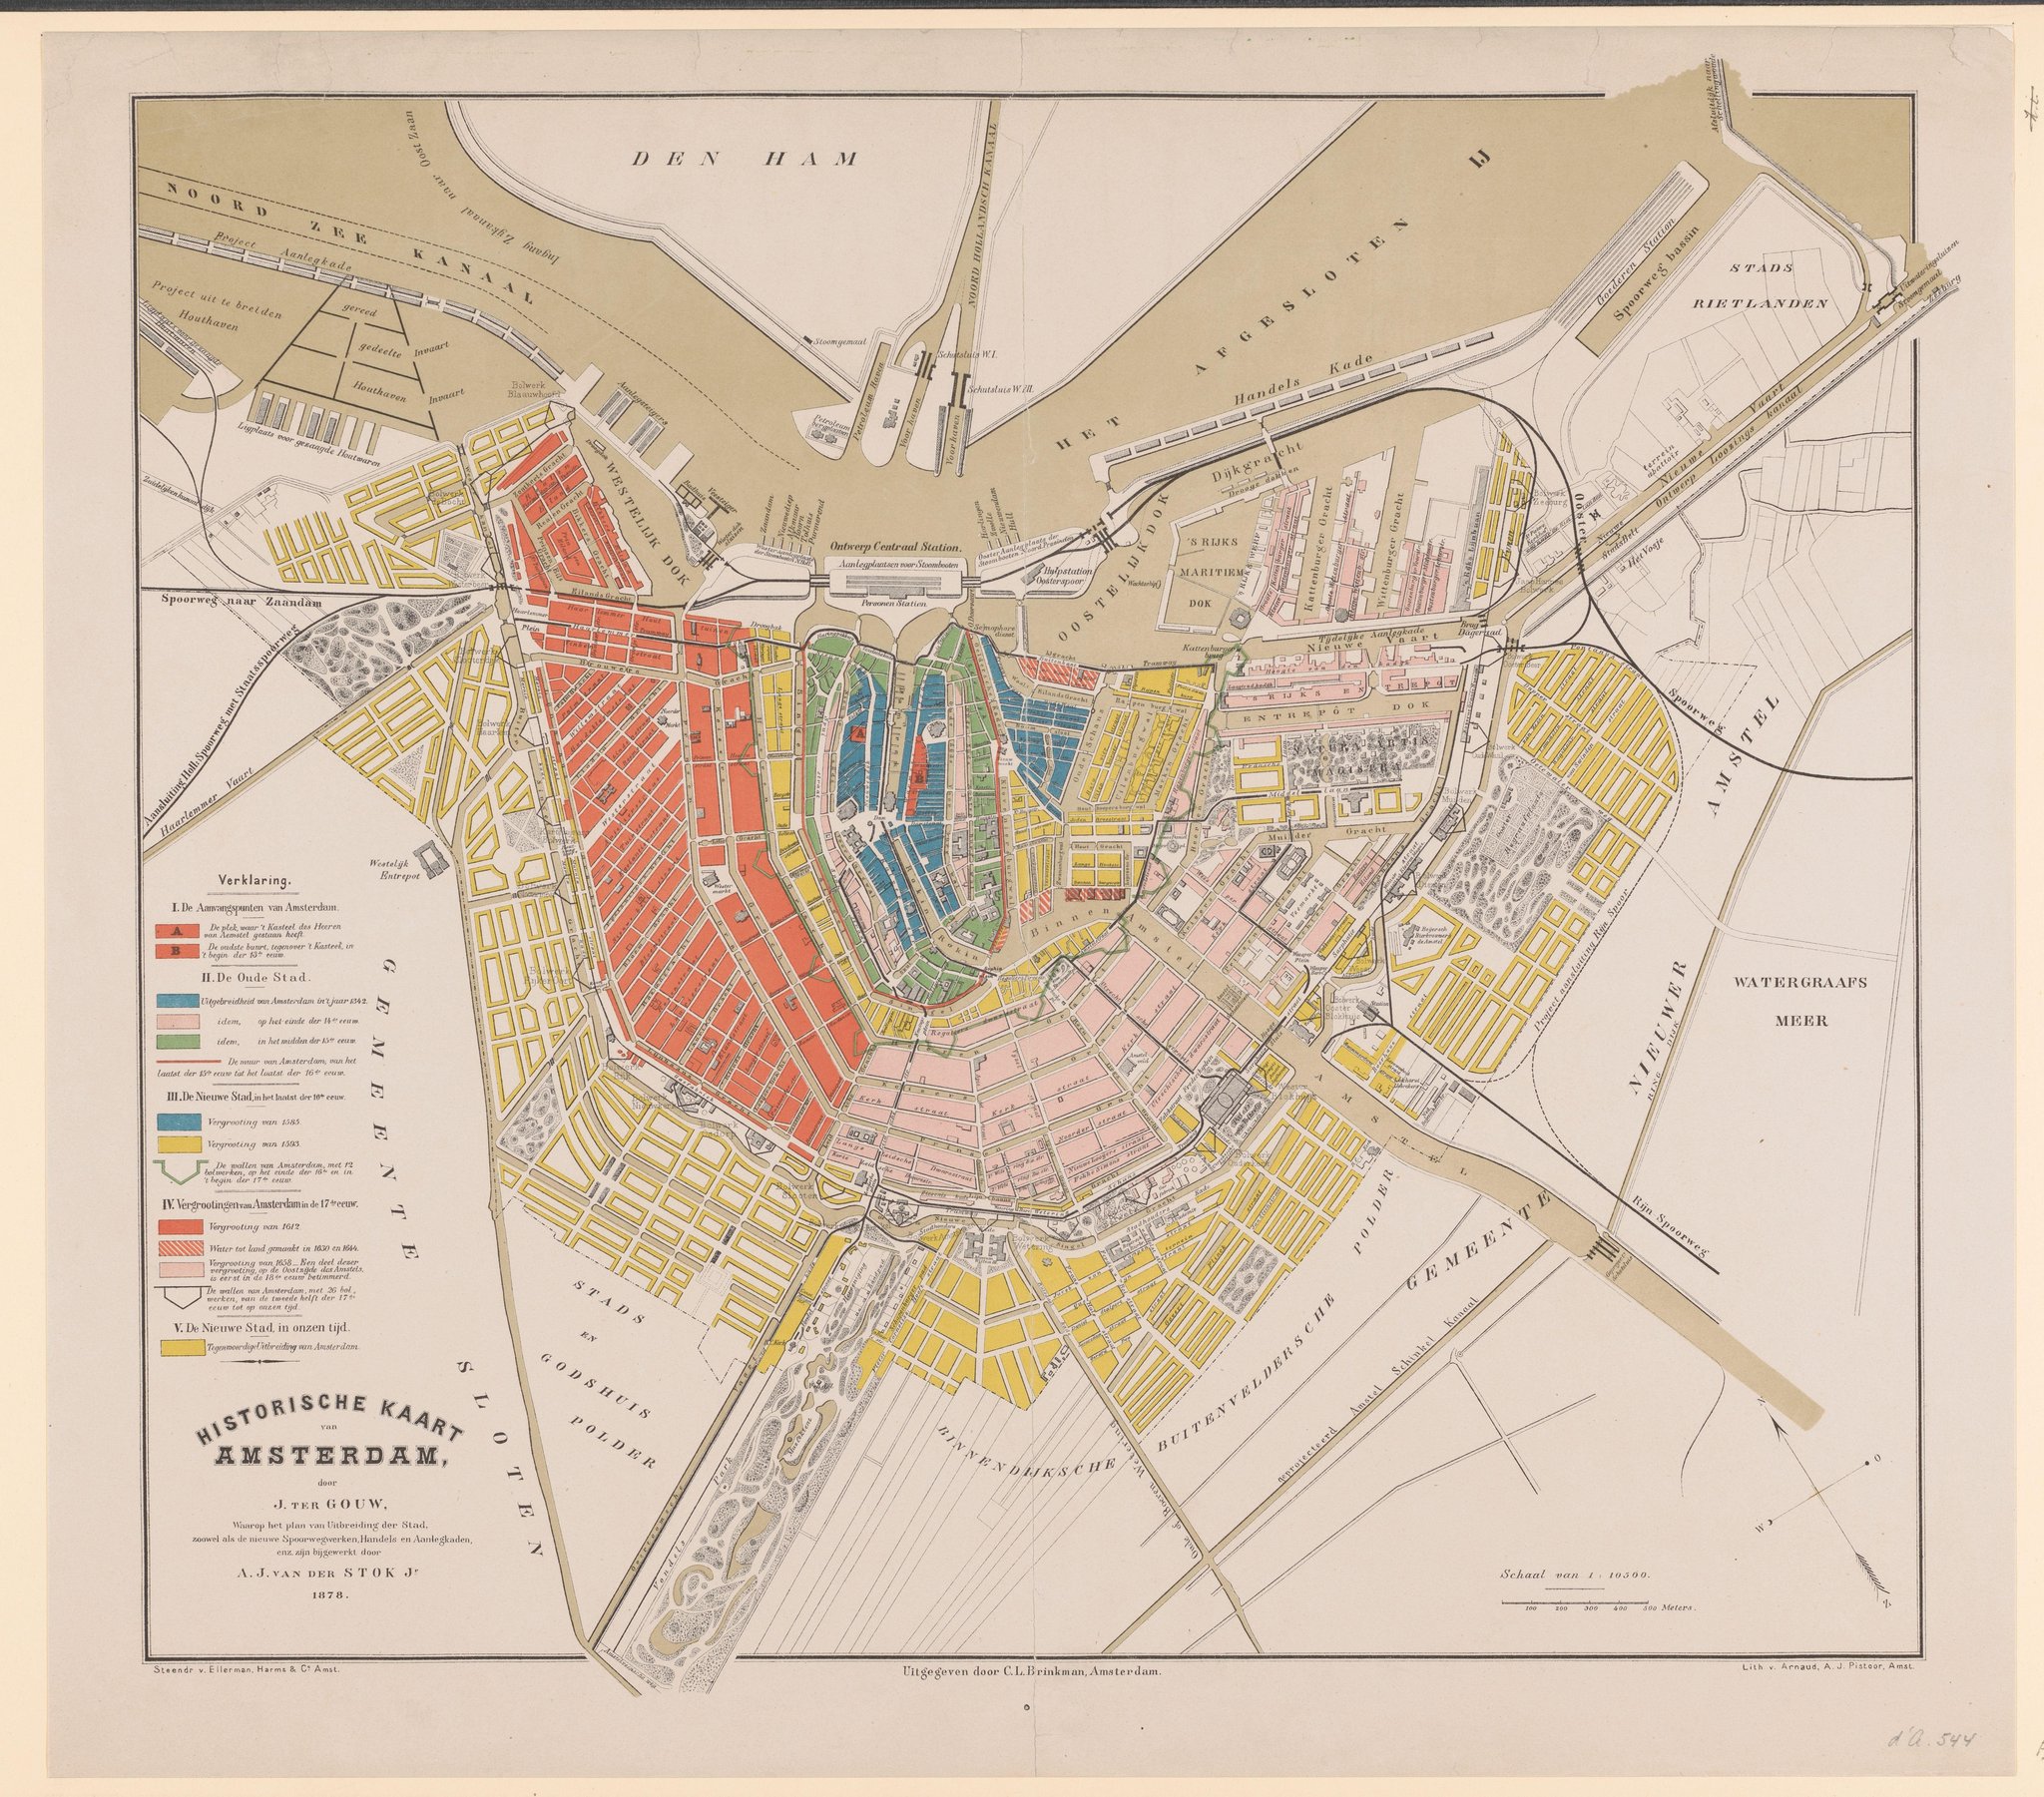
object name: area plan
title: Historische kaart van Amsterdam (...) waarop het plan van Uitbreiding der stad, zoowel als de nieuwe spoorwegstukken, handels- en aanlegkaden, enz. zijn bijgewerkt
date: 1878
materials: paper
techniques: lithograph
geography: amsterdam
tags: maps of cities, amsterdam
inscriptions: date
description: De kaart kon als bijlage worden toegevoegd aan: Gouw, J. ter. Geschiedenis van Amsterdam. Amsterdam: Scheltema & Holkema, 1879-1894.